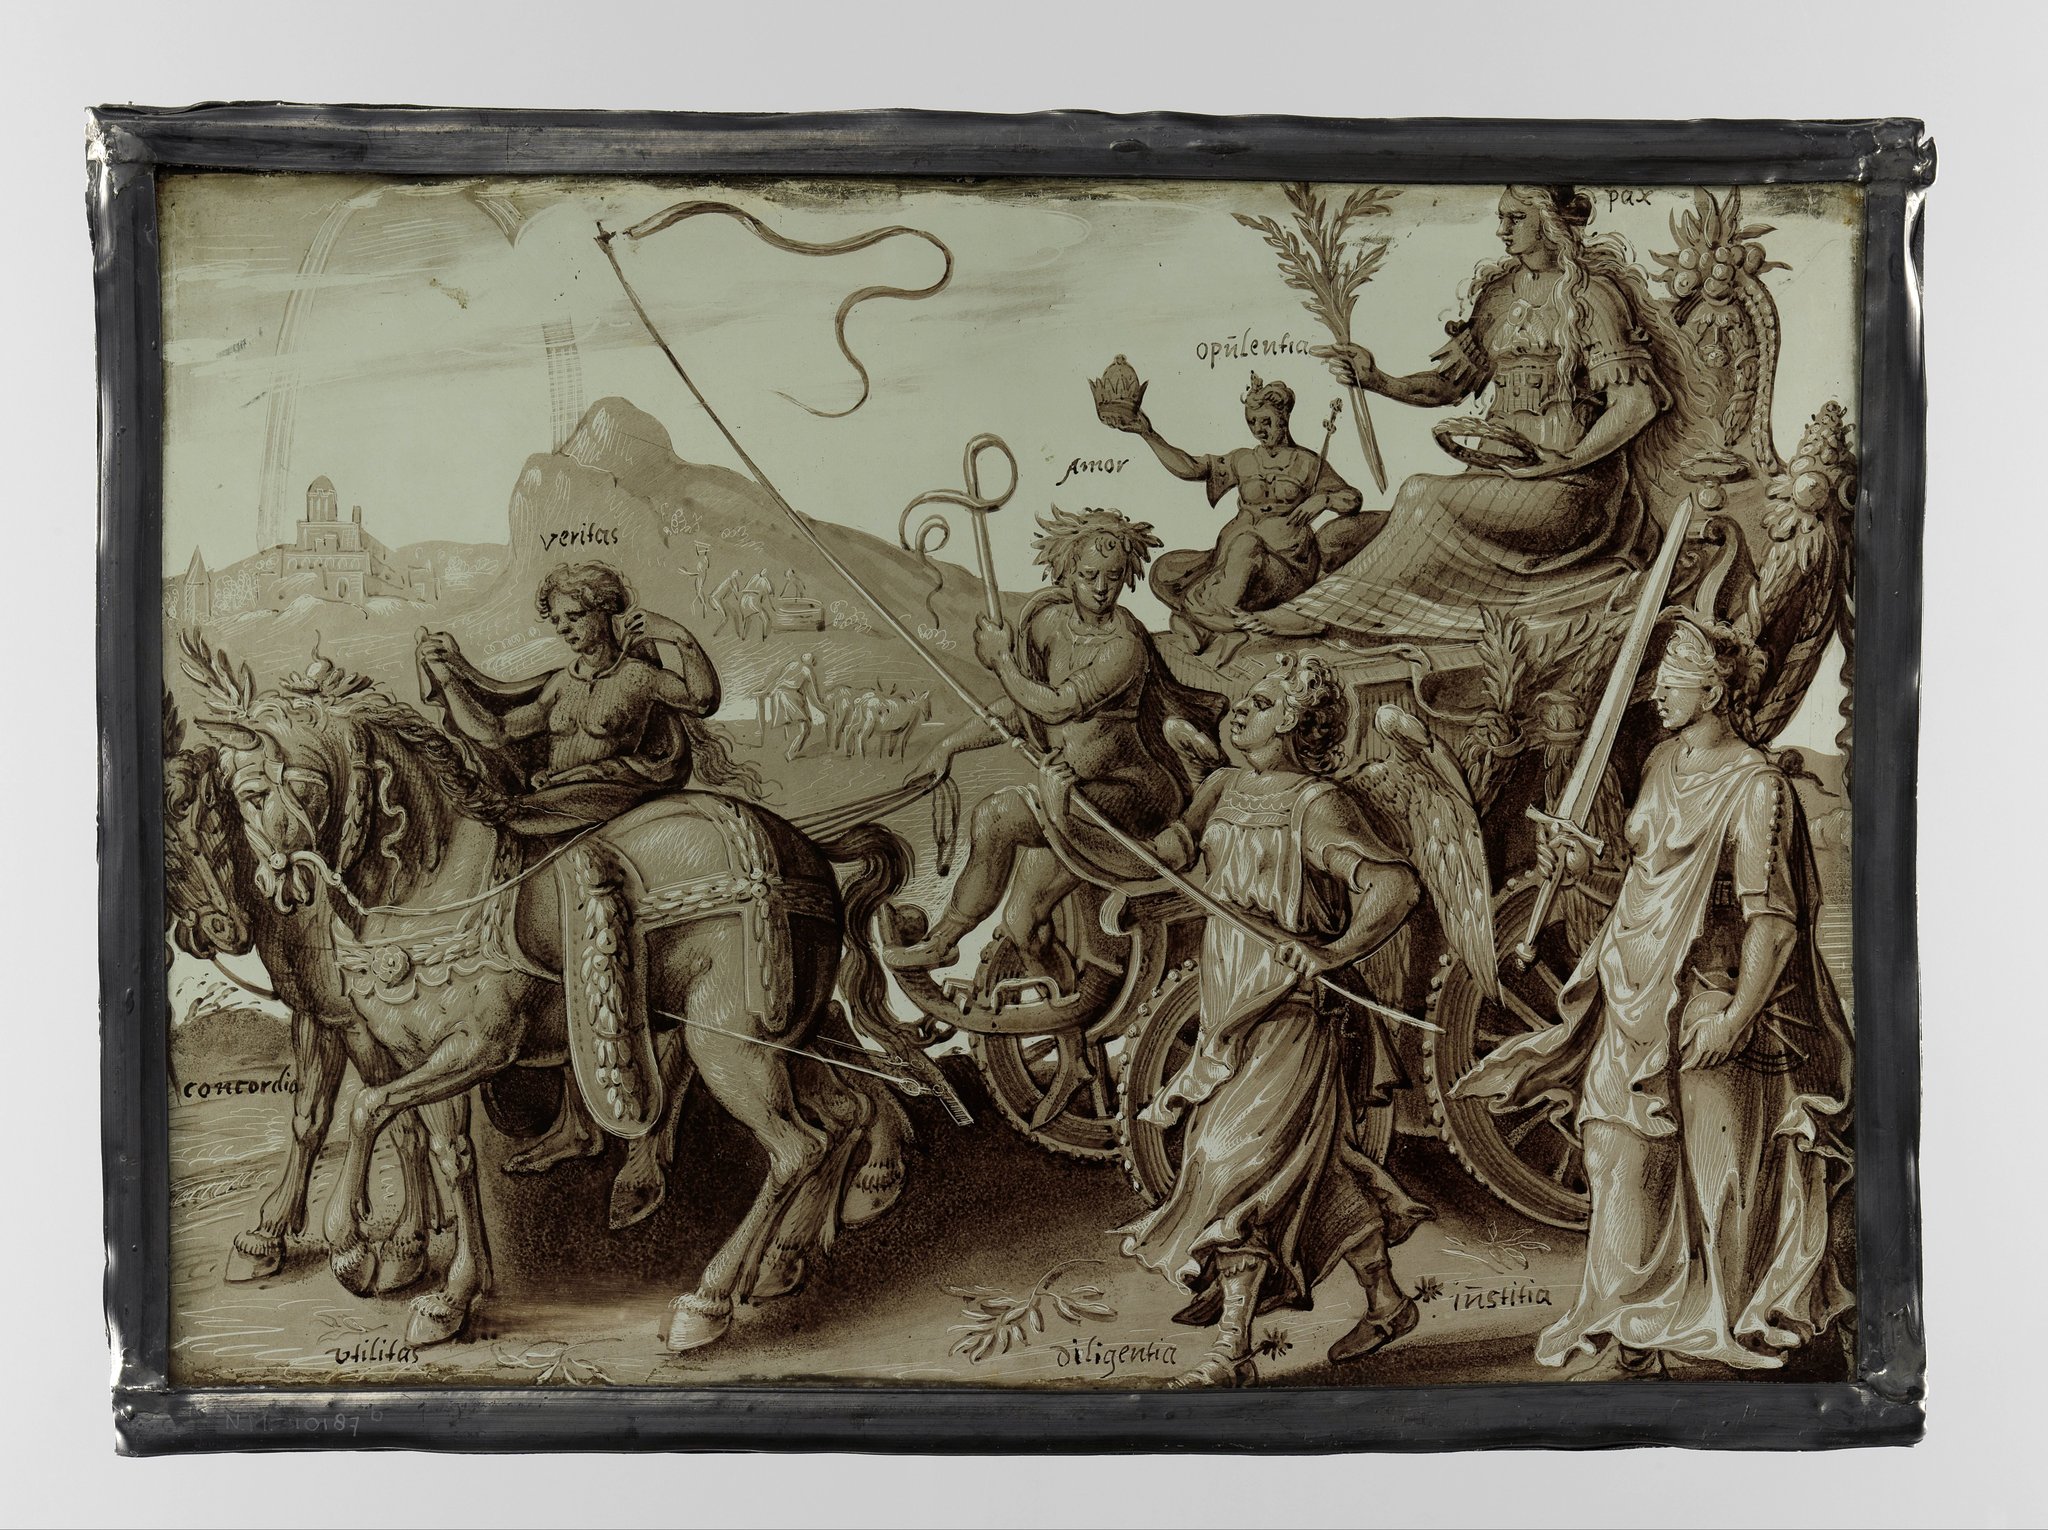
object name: light window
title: Ruit met De Triomf van de Vrede (Pax)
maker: Anonymous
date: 1564-1600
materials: glass, lead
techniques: leading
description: Ruit De Triomf van de Vrede. Pax in een triomfwagen.